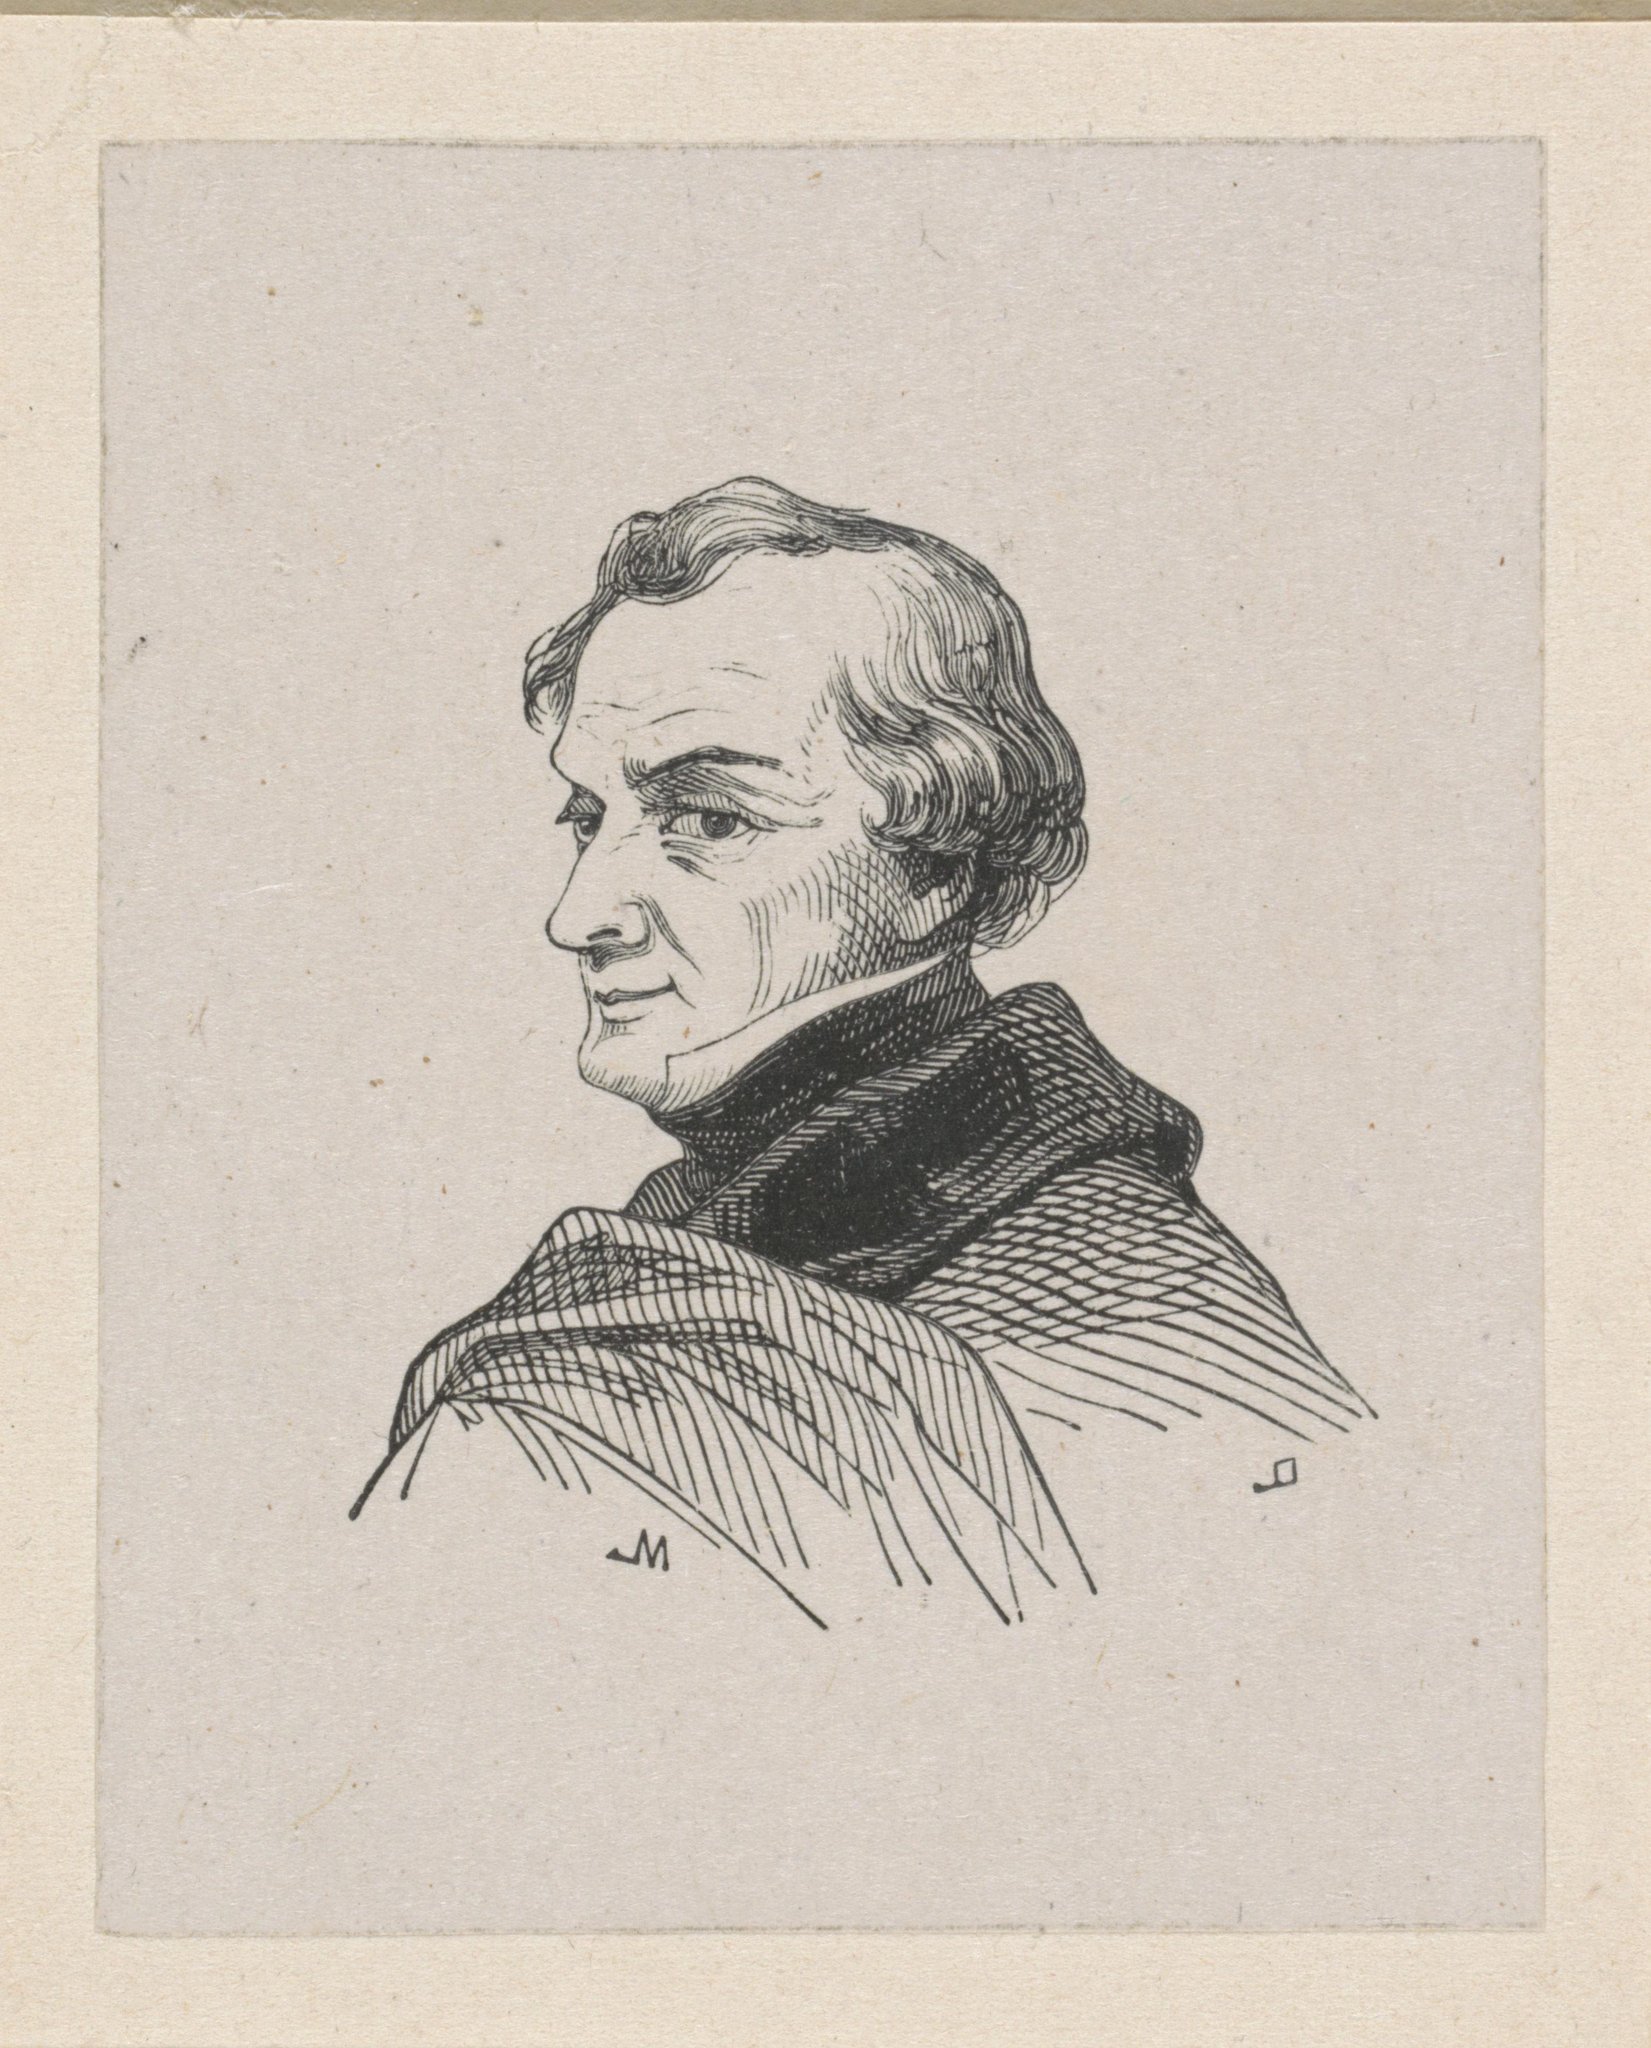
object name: print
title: Portret van Peter Paul Joseph Noël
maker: monogrammist ml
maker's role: print maker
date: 1800-1900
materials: paper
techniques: engraving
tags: painter, print maker, draughtsman, peter paul joseph noël, historical persons, portrait, self-portrait of artist